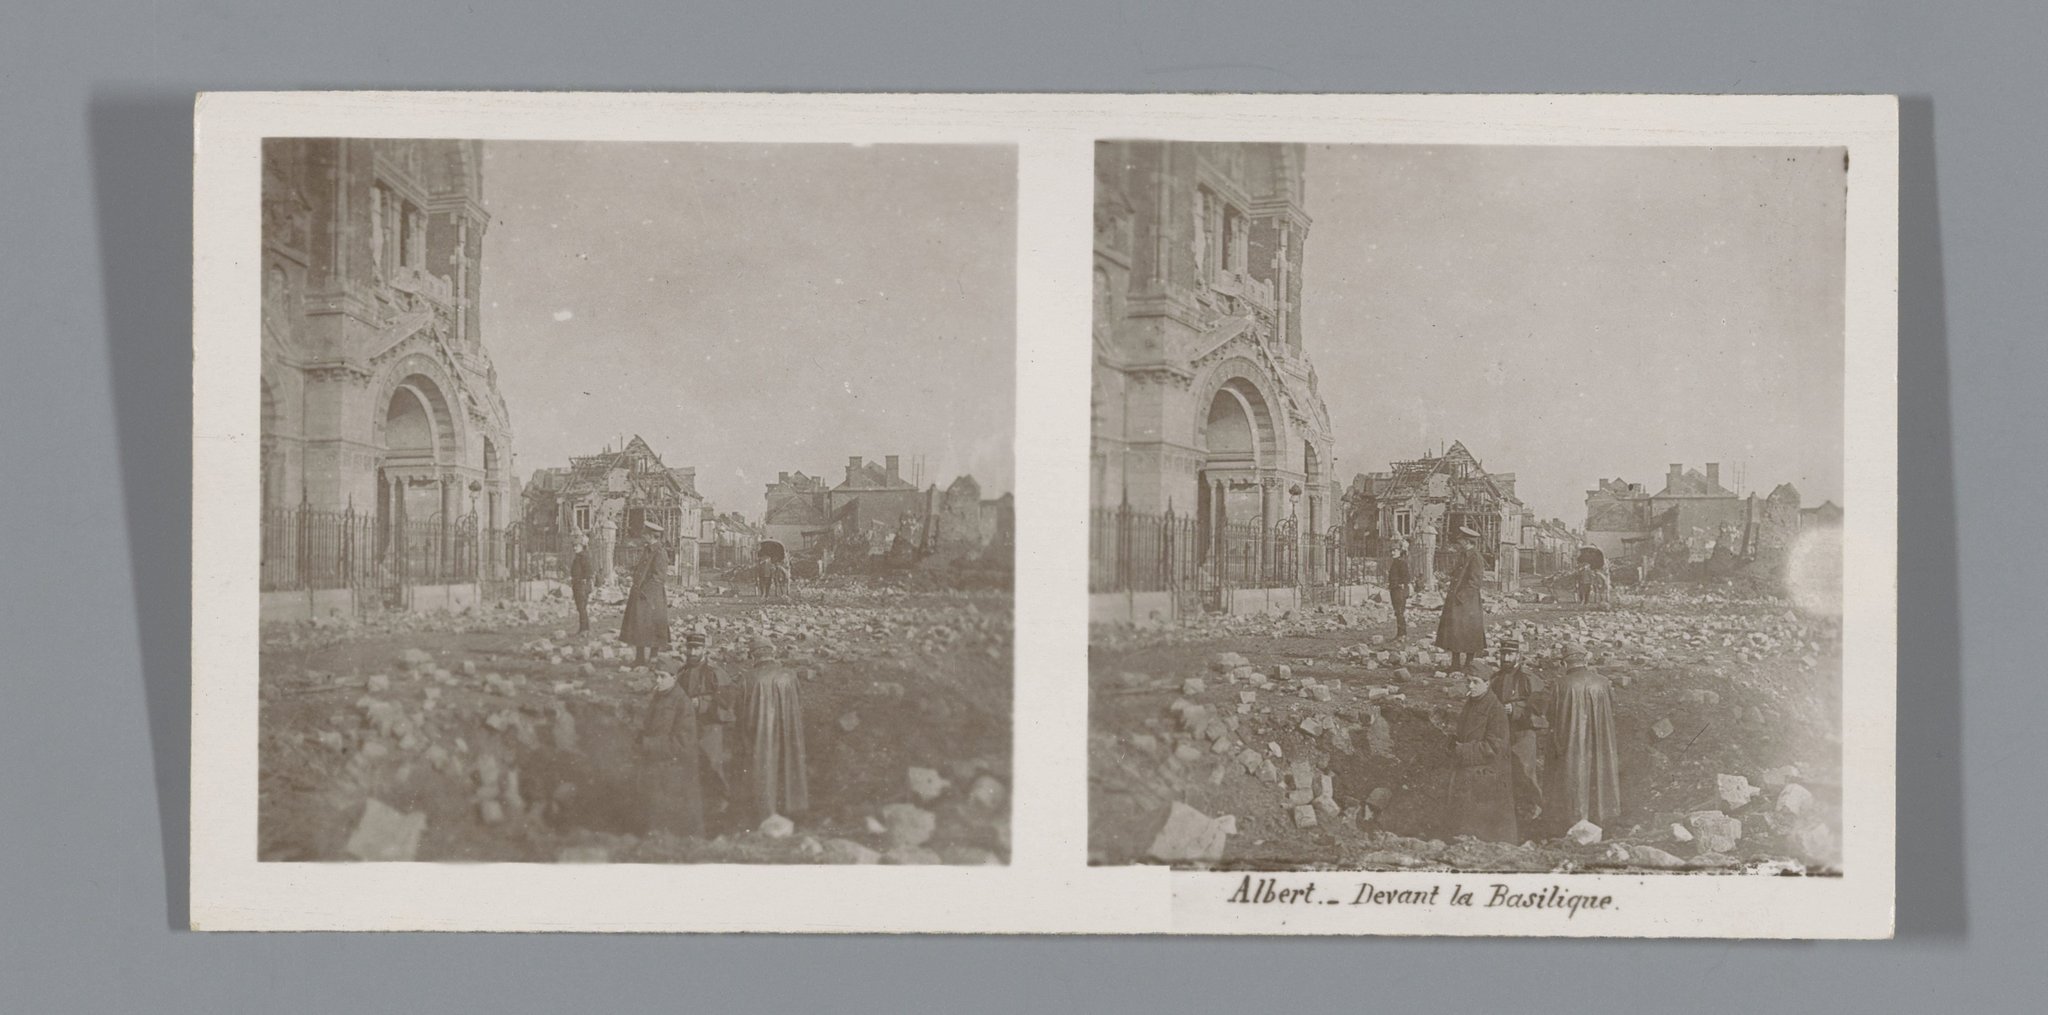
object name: stereograph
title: Albert.- Devant la Basilique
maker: Anonymous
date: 1914-1918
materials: cardboard, photographic support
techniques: gelatin silver print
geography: albert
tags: ruin of a building ~ architecture, private soldier, church (exterior)